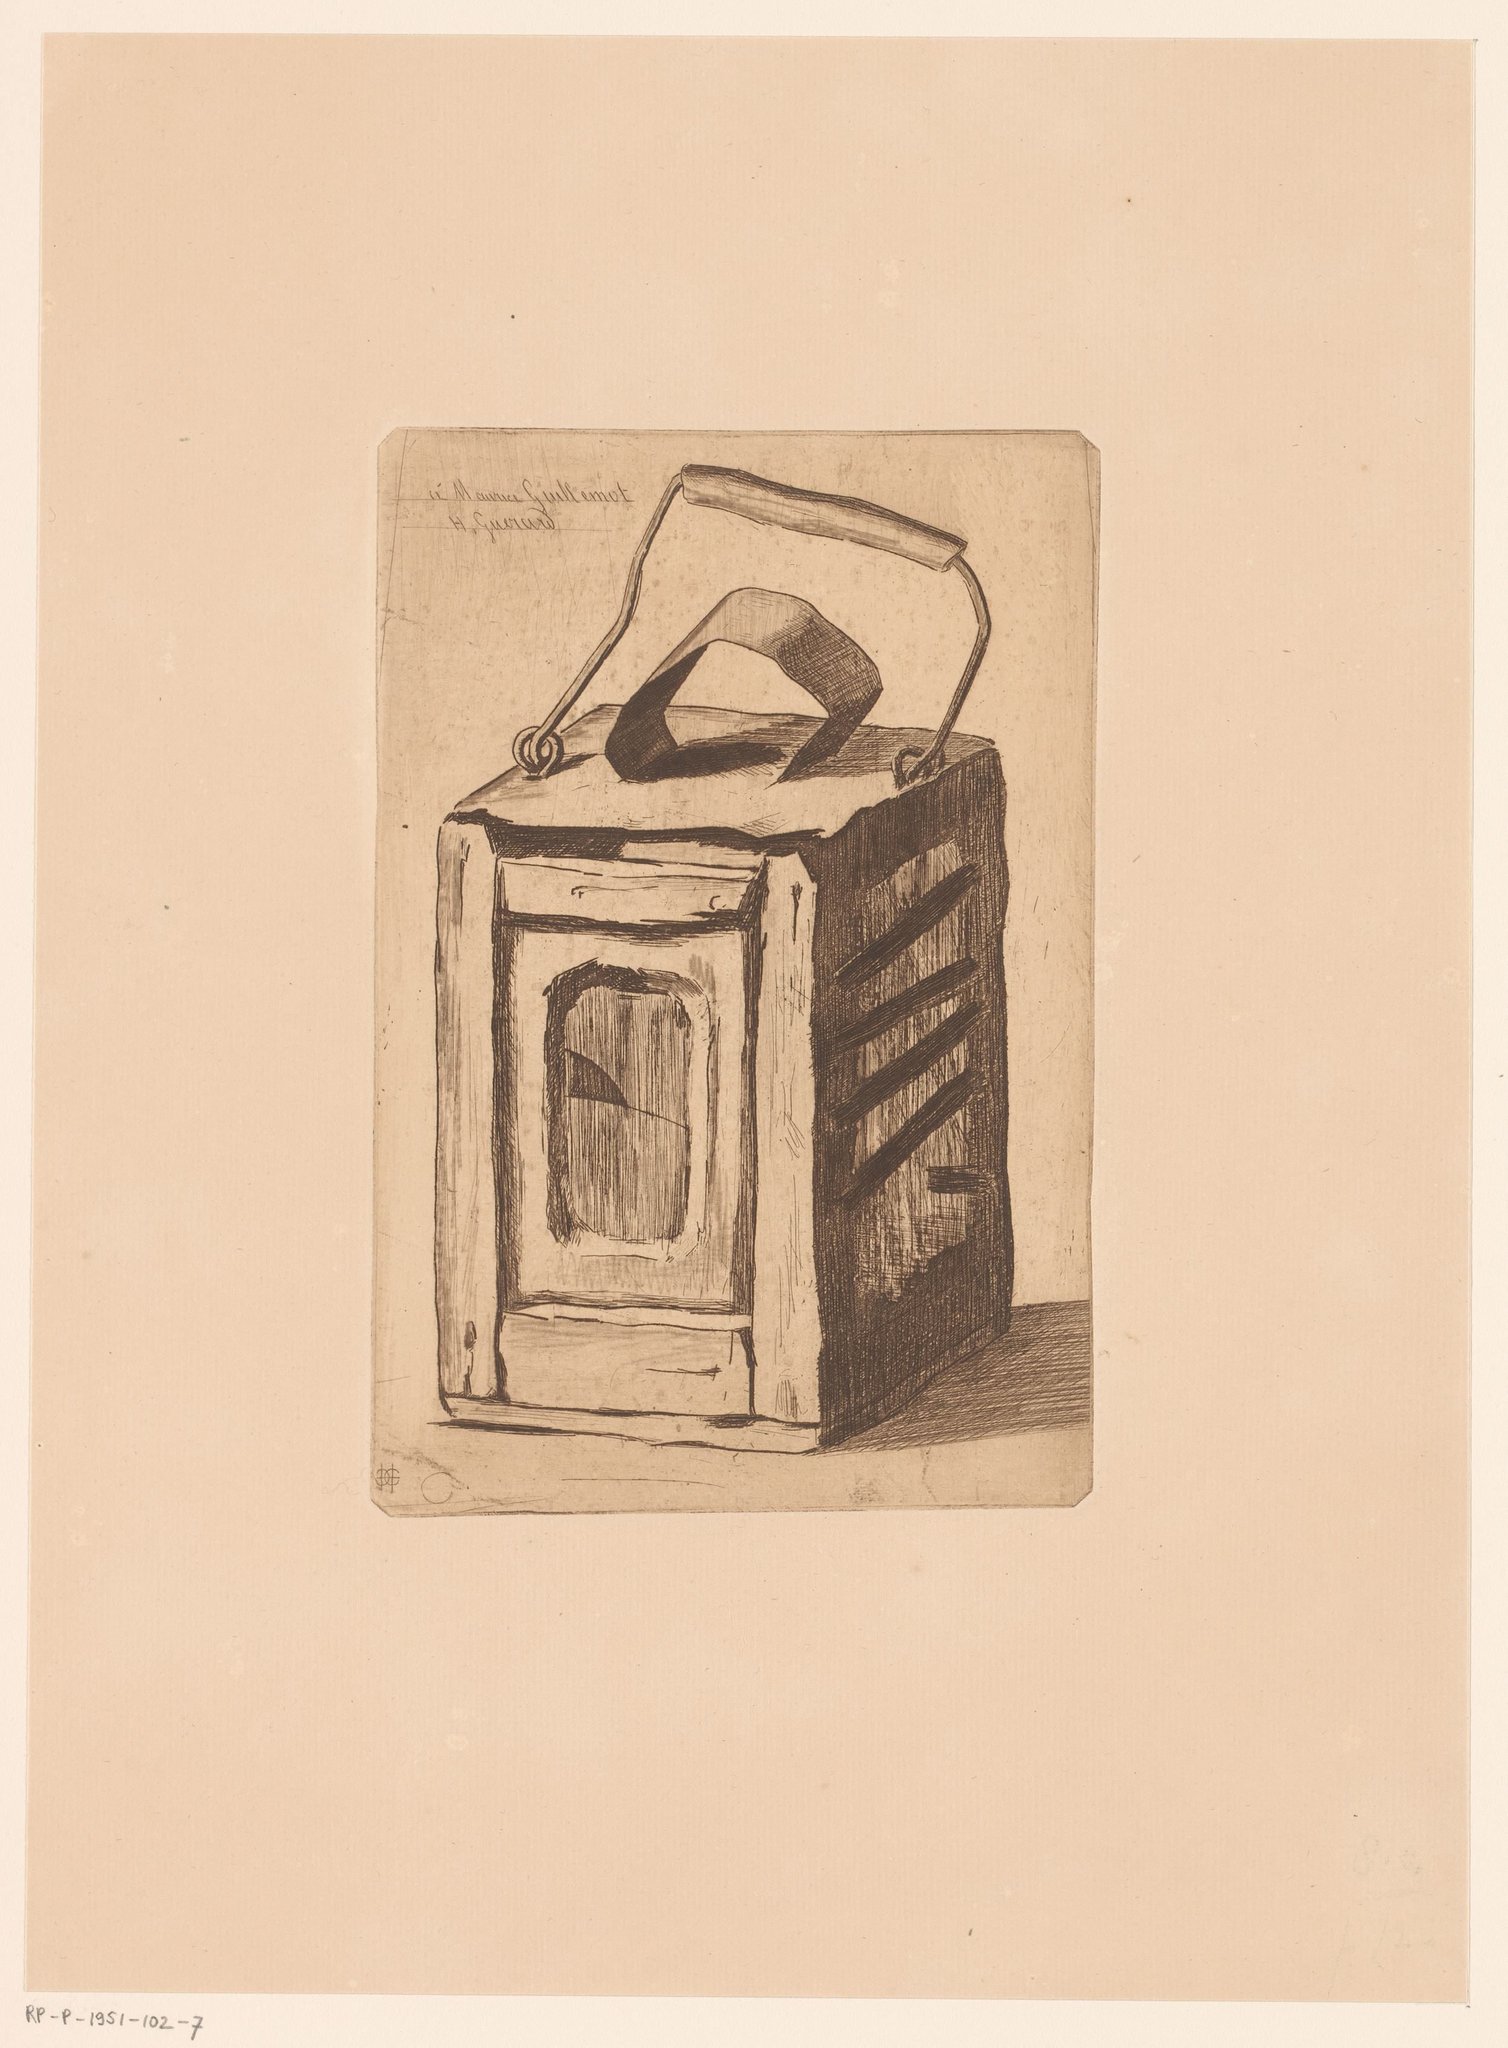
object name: print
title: Les Lanternes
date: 1876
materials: paper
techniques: etching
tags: lantern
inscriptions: collector's mark: Lugt 2228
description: Maakt waarschijnlijk deel uit van een tiendelige serie met lantaarns.